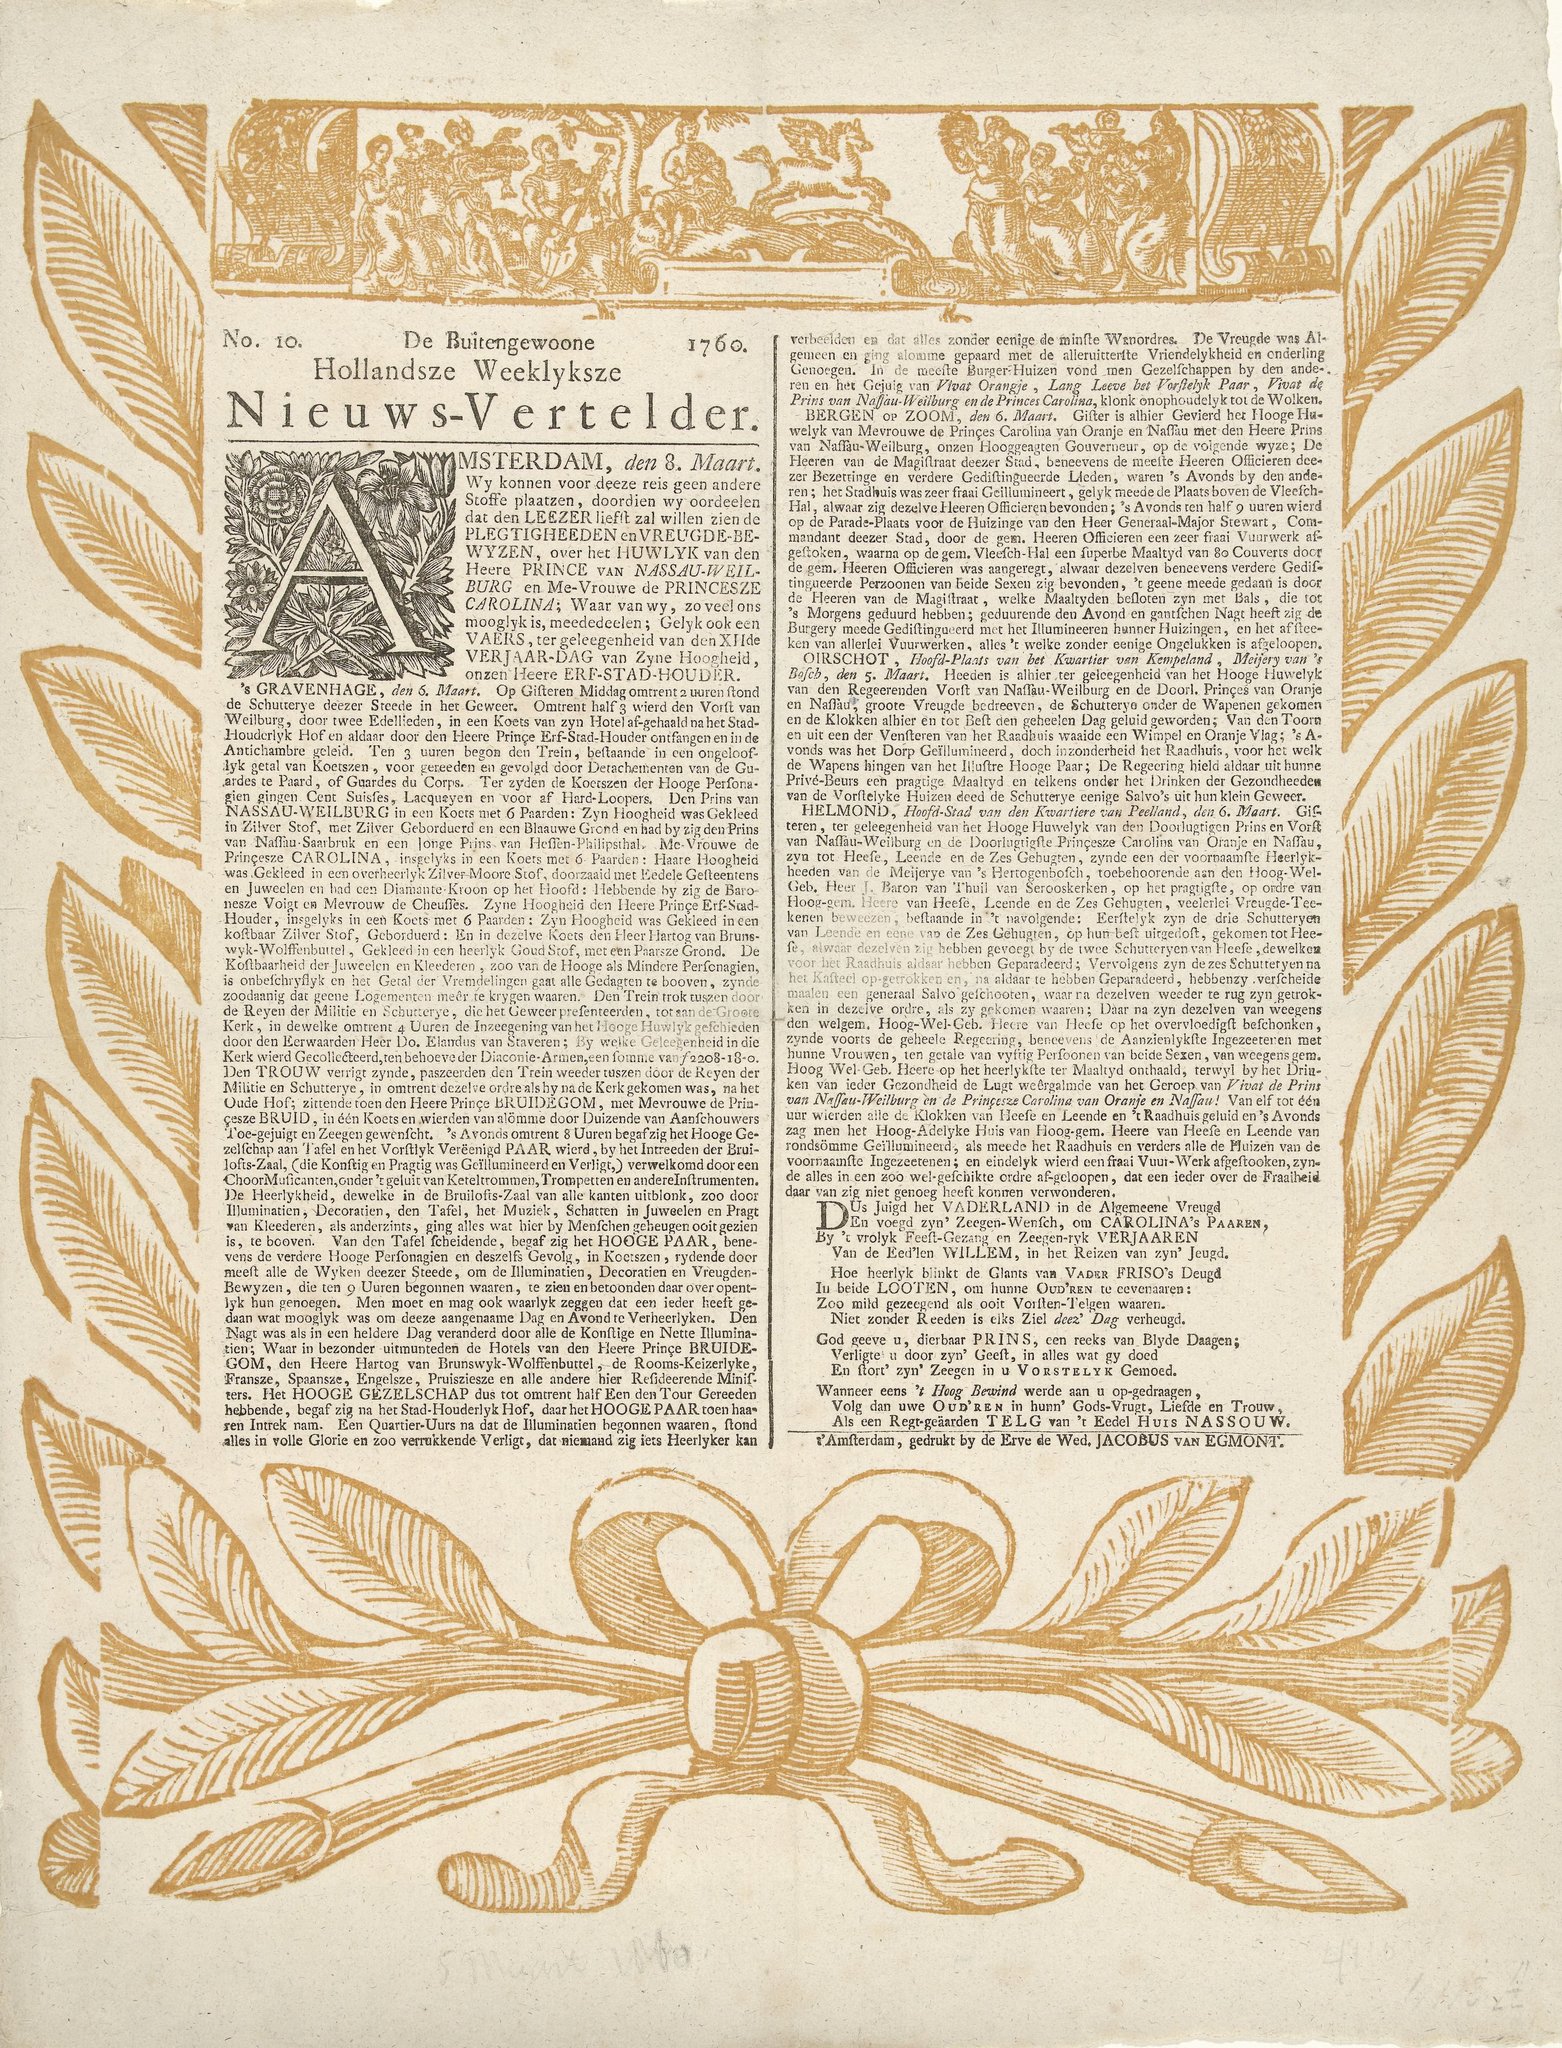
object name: print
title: De Buitengewoone Hollandsze Weeklyksze Nieuws-Vertelder. No. 10. 1760.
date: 1760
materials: paper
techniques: printing, letterpress printing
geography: amsterdam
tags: carolina (prinses van oranje-nassau), karel christiaan vorst van nassau-weilburg, apollo and the muses, apollo musagetes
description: Blad met een gedrukte beschrijving van het huwelijk van Karel Christiaan van Nassau-Weilburg met prinses Carolina in de Grote Kerk te Den Haag op 5 maart 1760. Tekst beginnend met een gedecoreerde inititaal A in een decoratieve rand met bladeren, bovenaan een vignet met Apollo en de Muzen op de Parnassus.